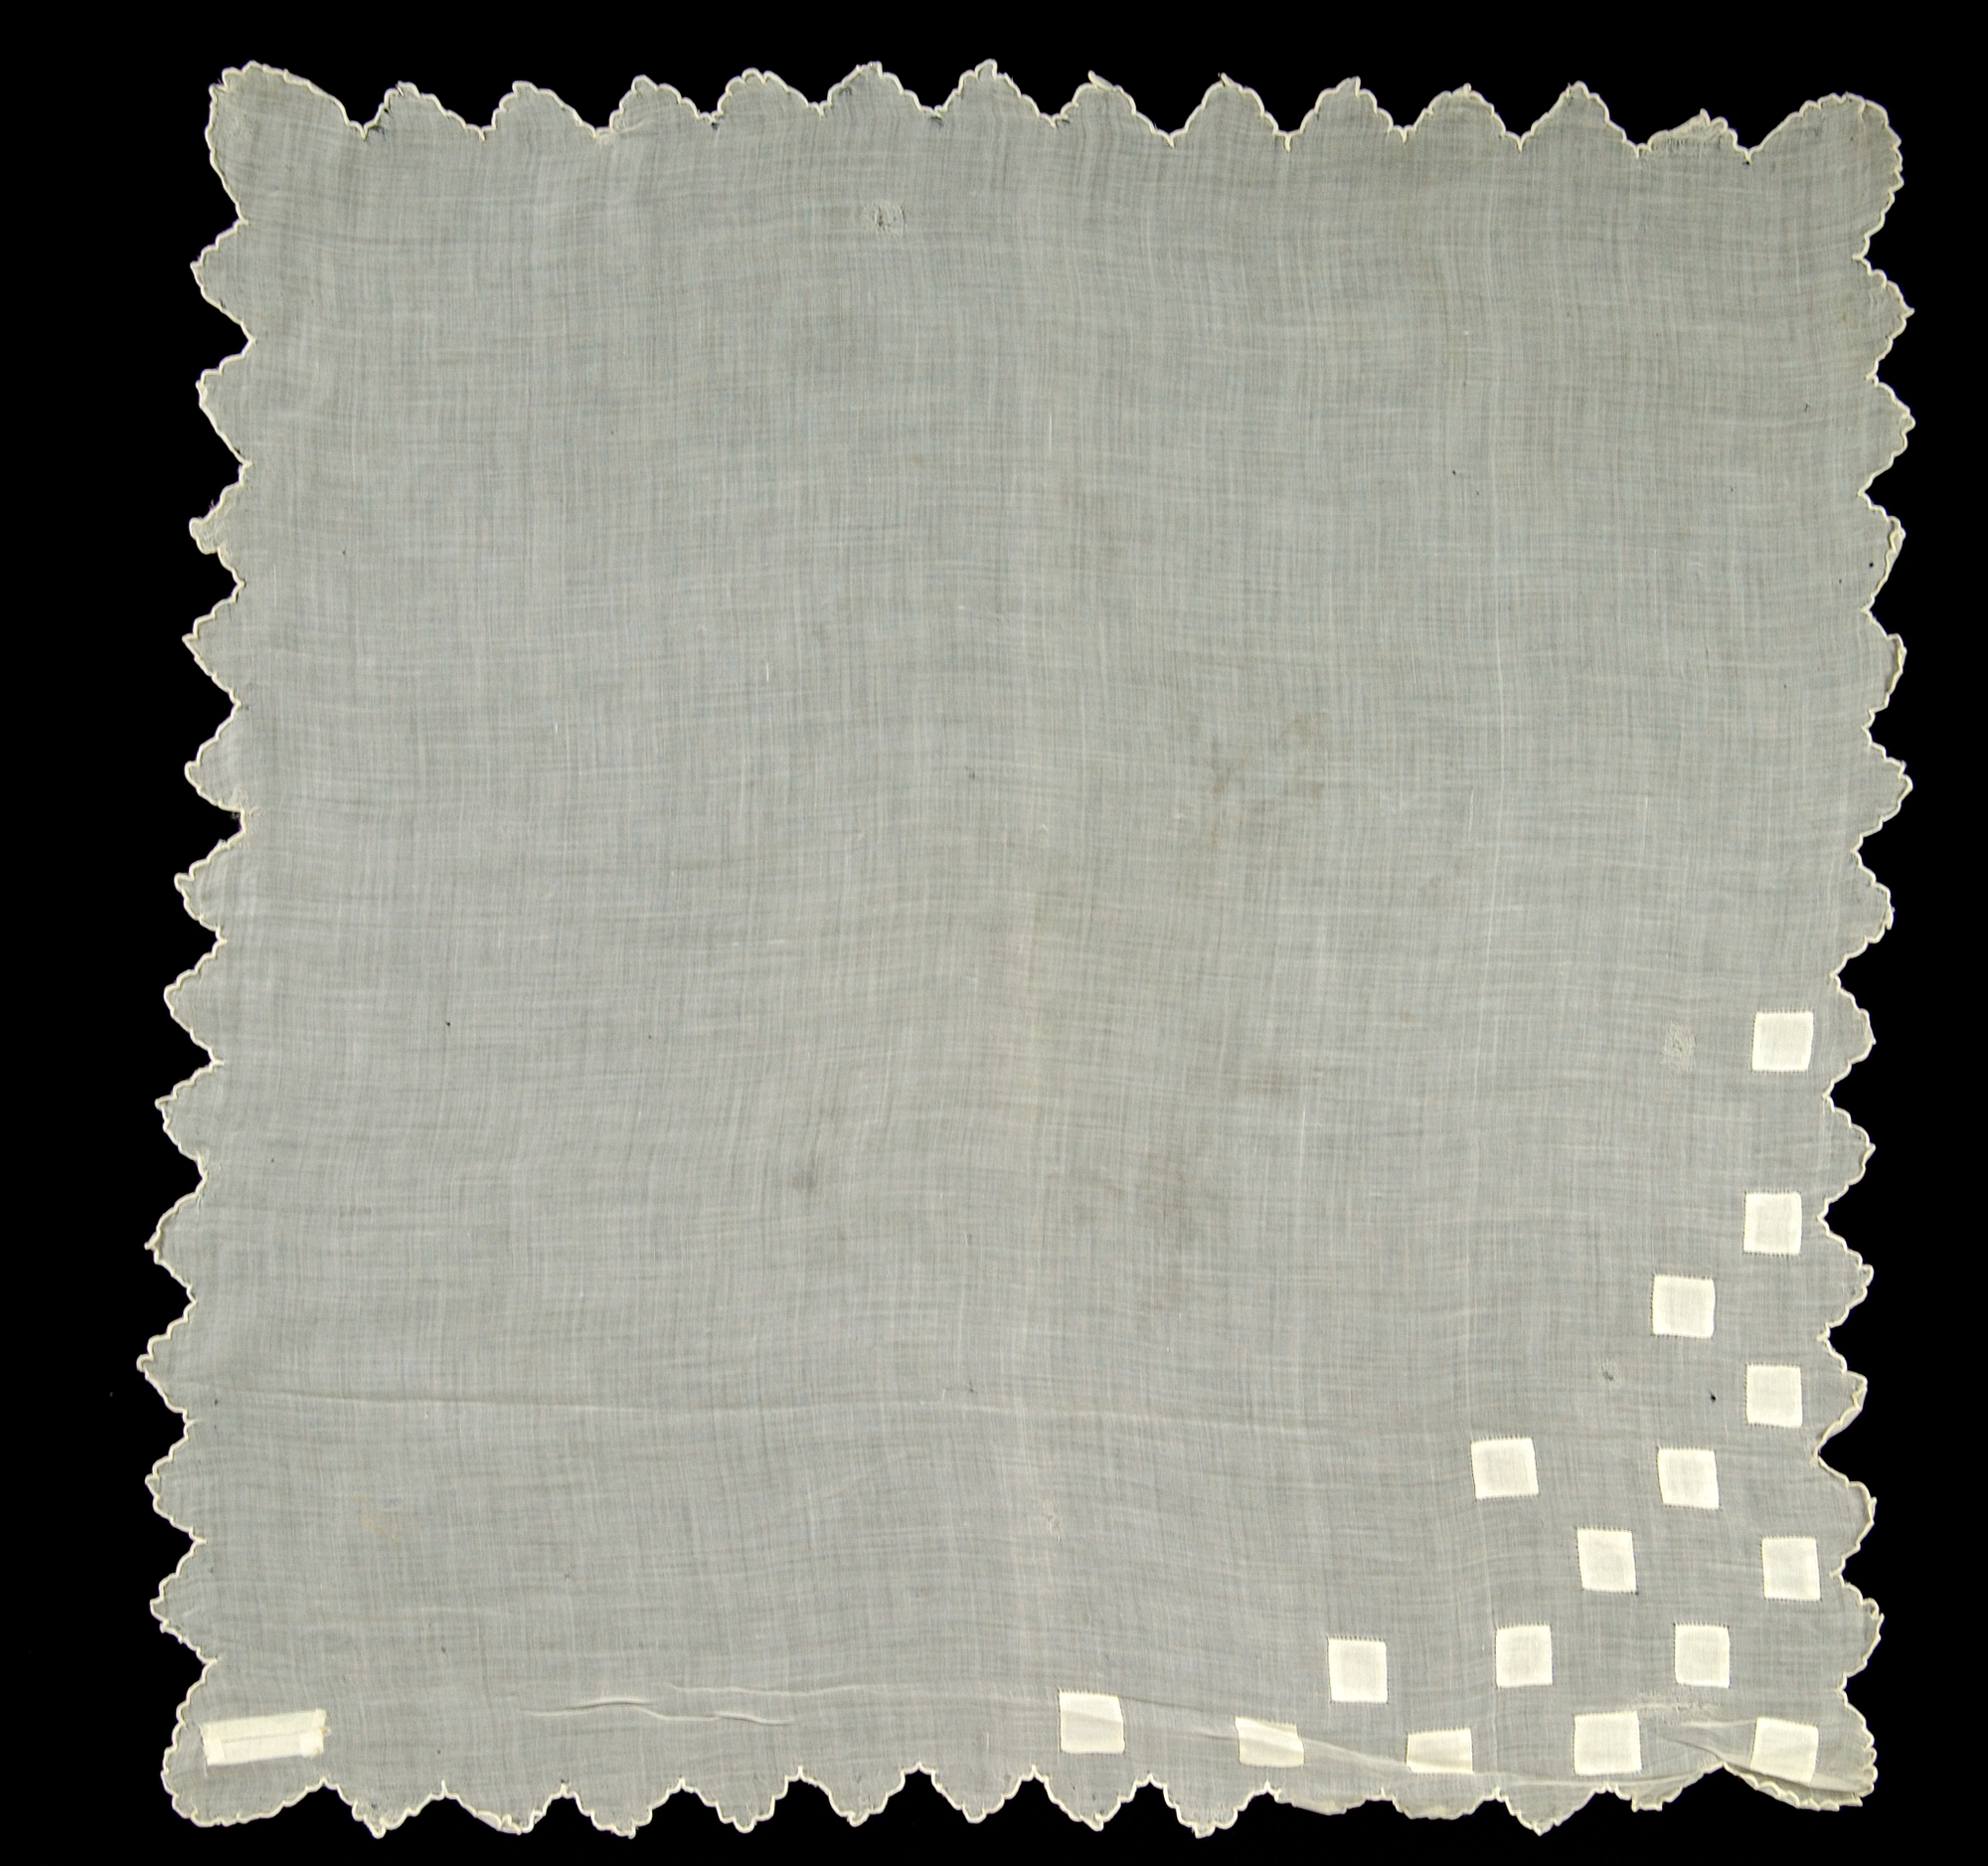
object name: fichu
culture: american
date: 1843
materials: cotton